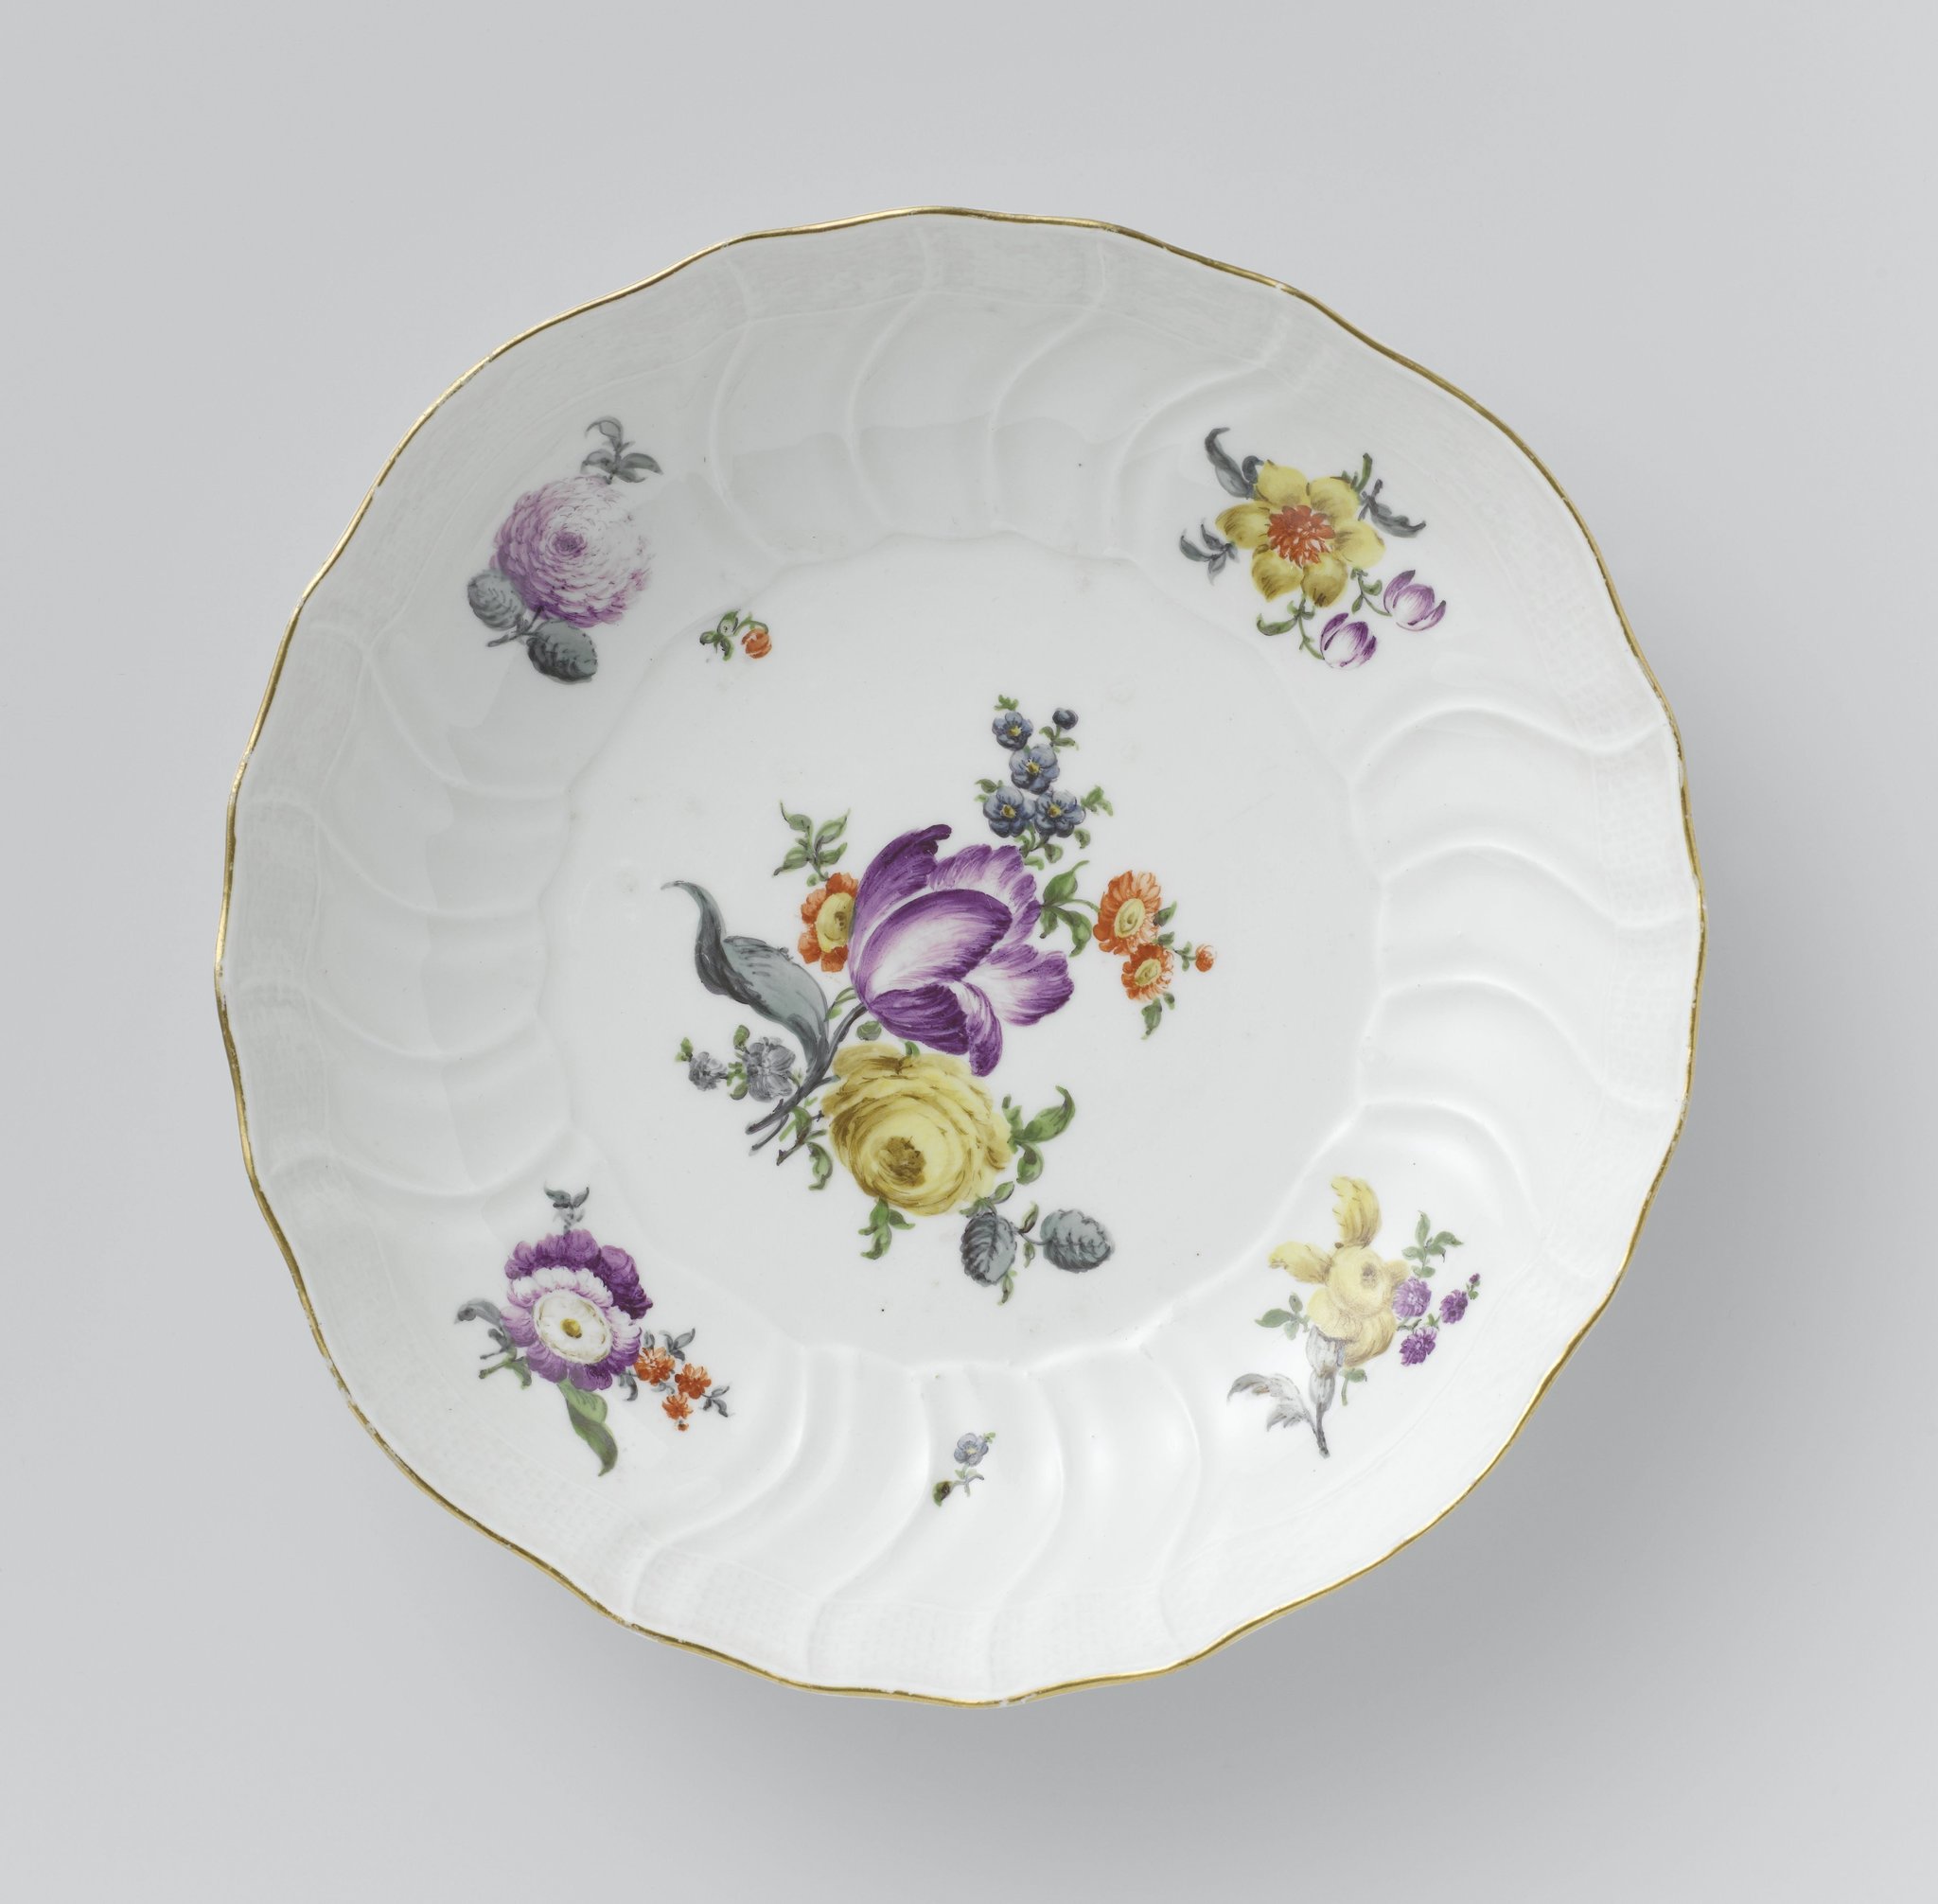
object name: platter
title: Schotel, veelkleurig beschilderd met Deutsche Blumen, insekten en vruchten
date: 1750-1760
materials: porcelain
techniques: painted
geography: meissen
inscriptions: factory mark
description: Ronde schotel van beschilderd porselein. De schotel is beschilderd met Deutsche Blumen, insekten en vruchten. De rand is in reliëf versierd met het Neuozier-patroon. De schotel is gemerkt en hoort bij een servies (BK-17474-1 t/m BK-17474-253).